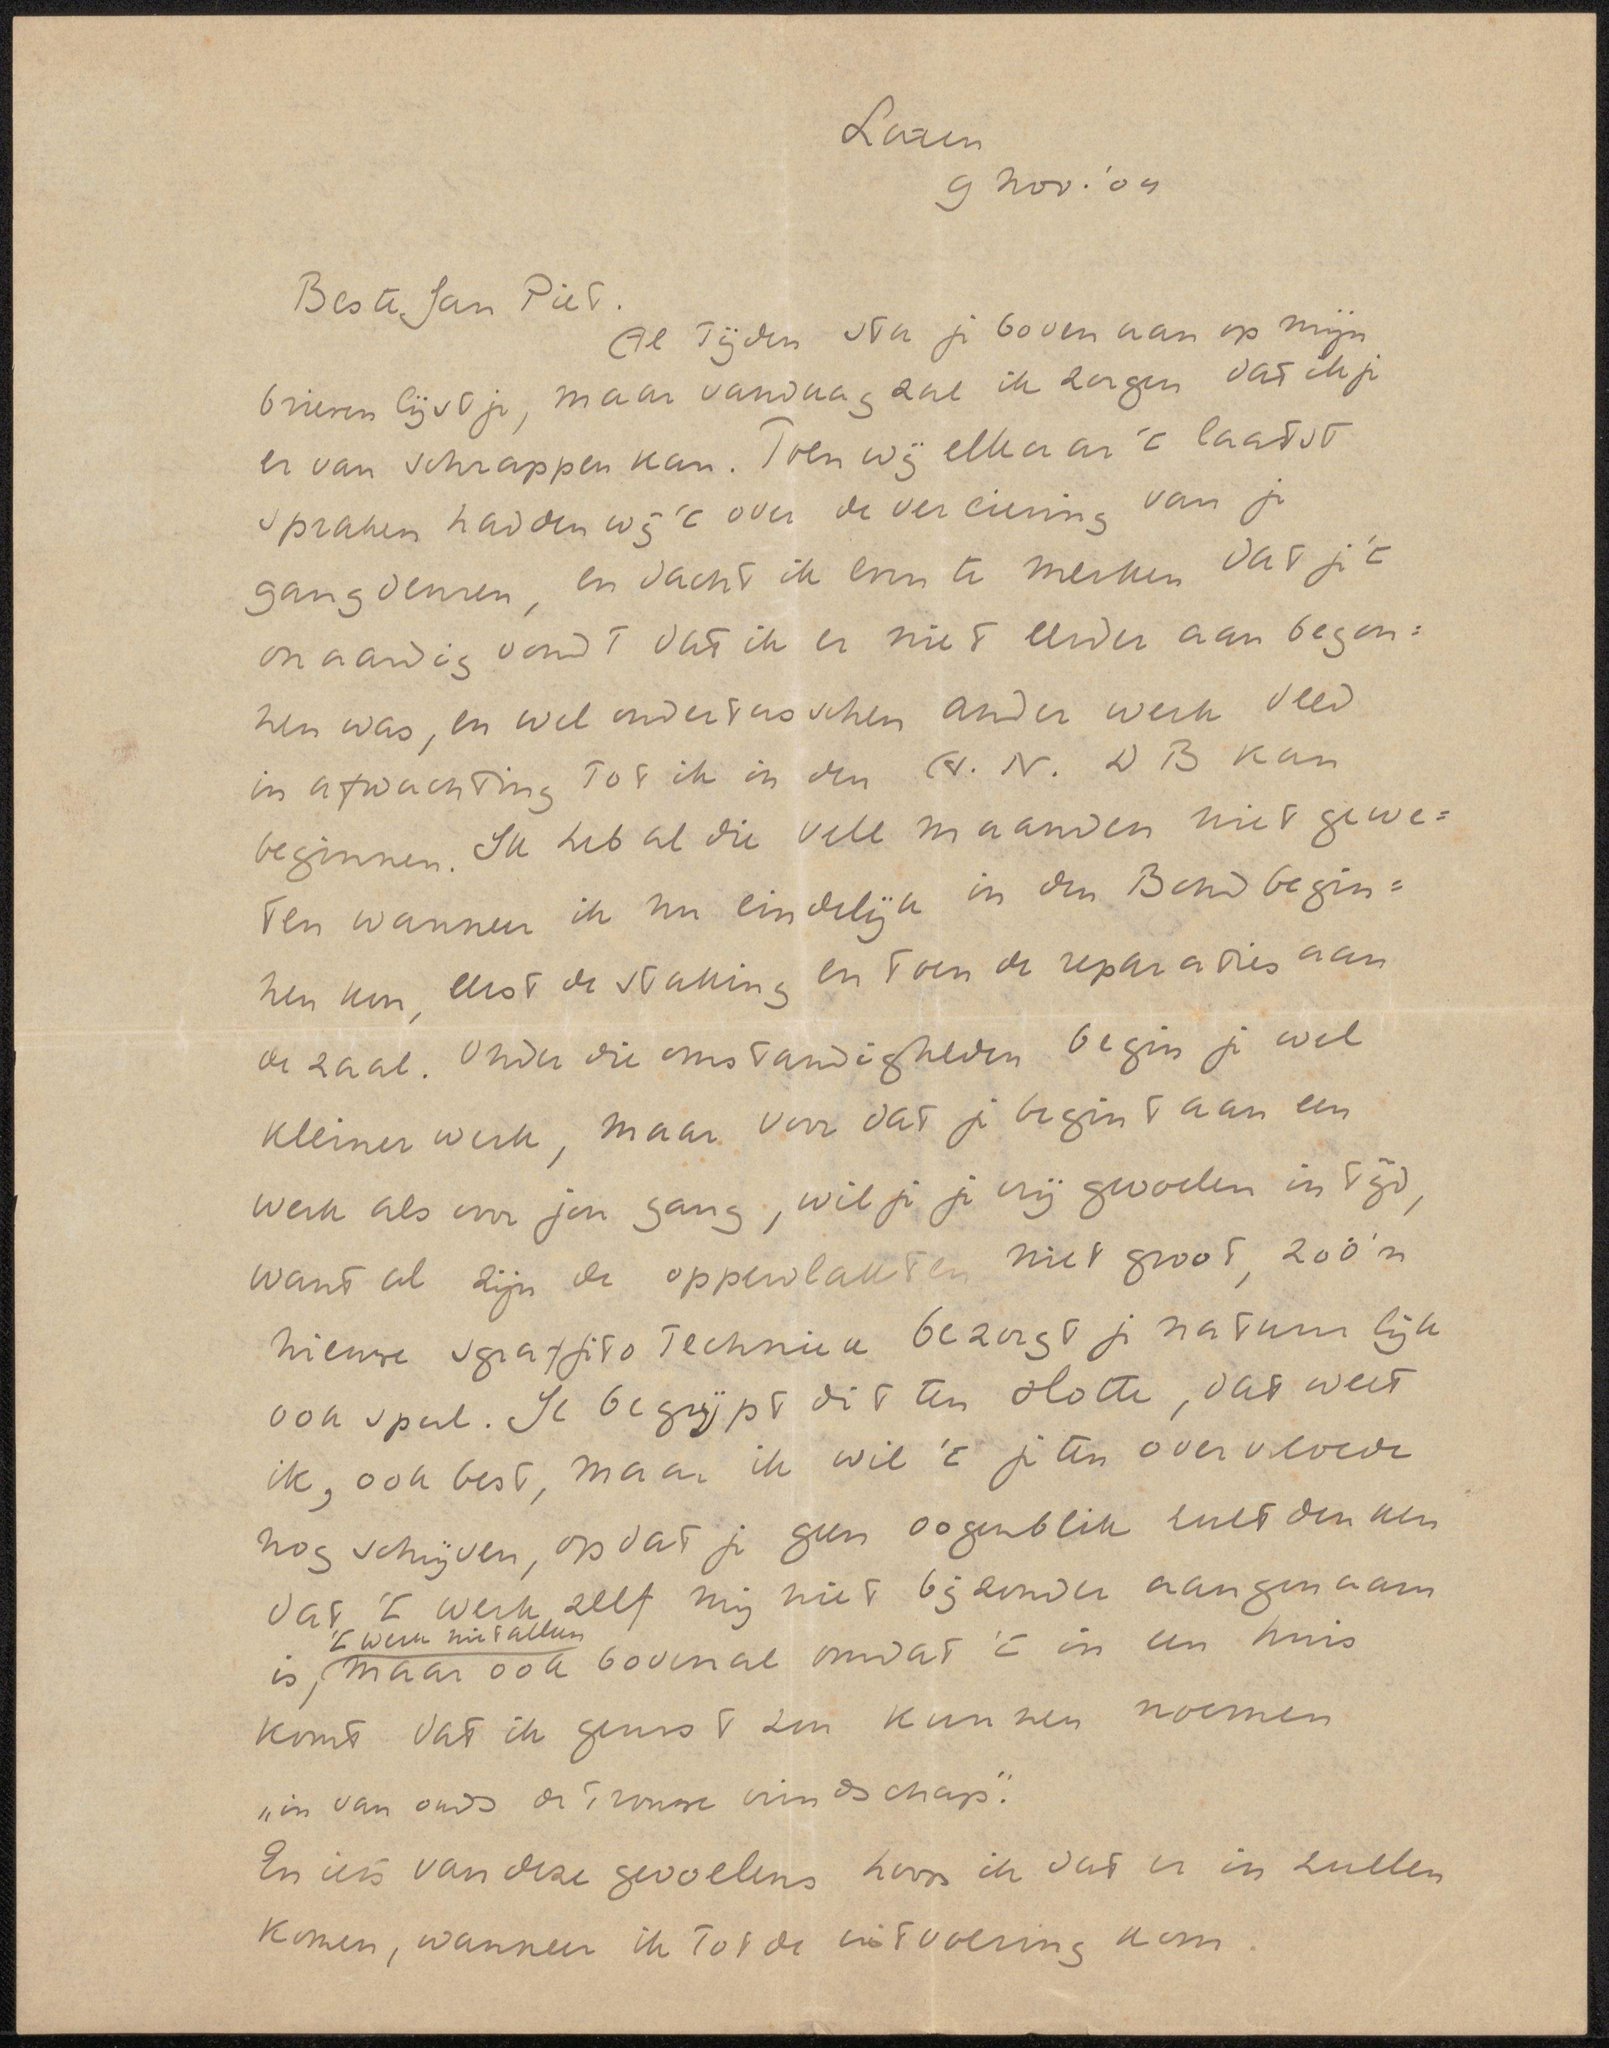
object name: letter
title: Brief aan Jan Veth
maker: richard nicolaüs roland holst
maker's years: 1868-1938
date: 1904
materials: ink, paper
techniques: pen, writing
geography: laren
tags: dordrecht, designer, jan veth, den bosch, amsterdam, painter, draughtsman, antoon derkinderen, the hague, theo van hoytema, wally moes, artist's model, sitter, drawing, the graphic arts, the monumental arts, anonymous historical person portrayed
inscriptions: collector's mark: ‘RPK’, watermark